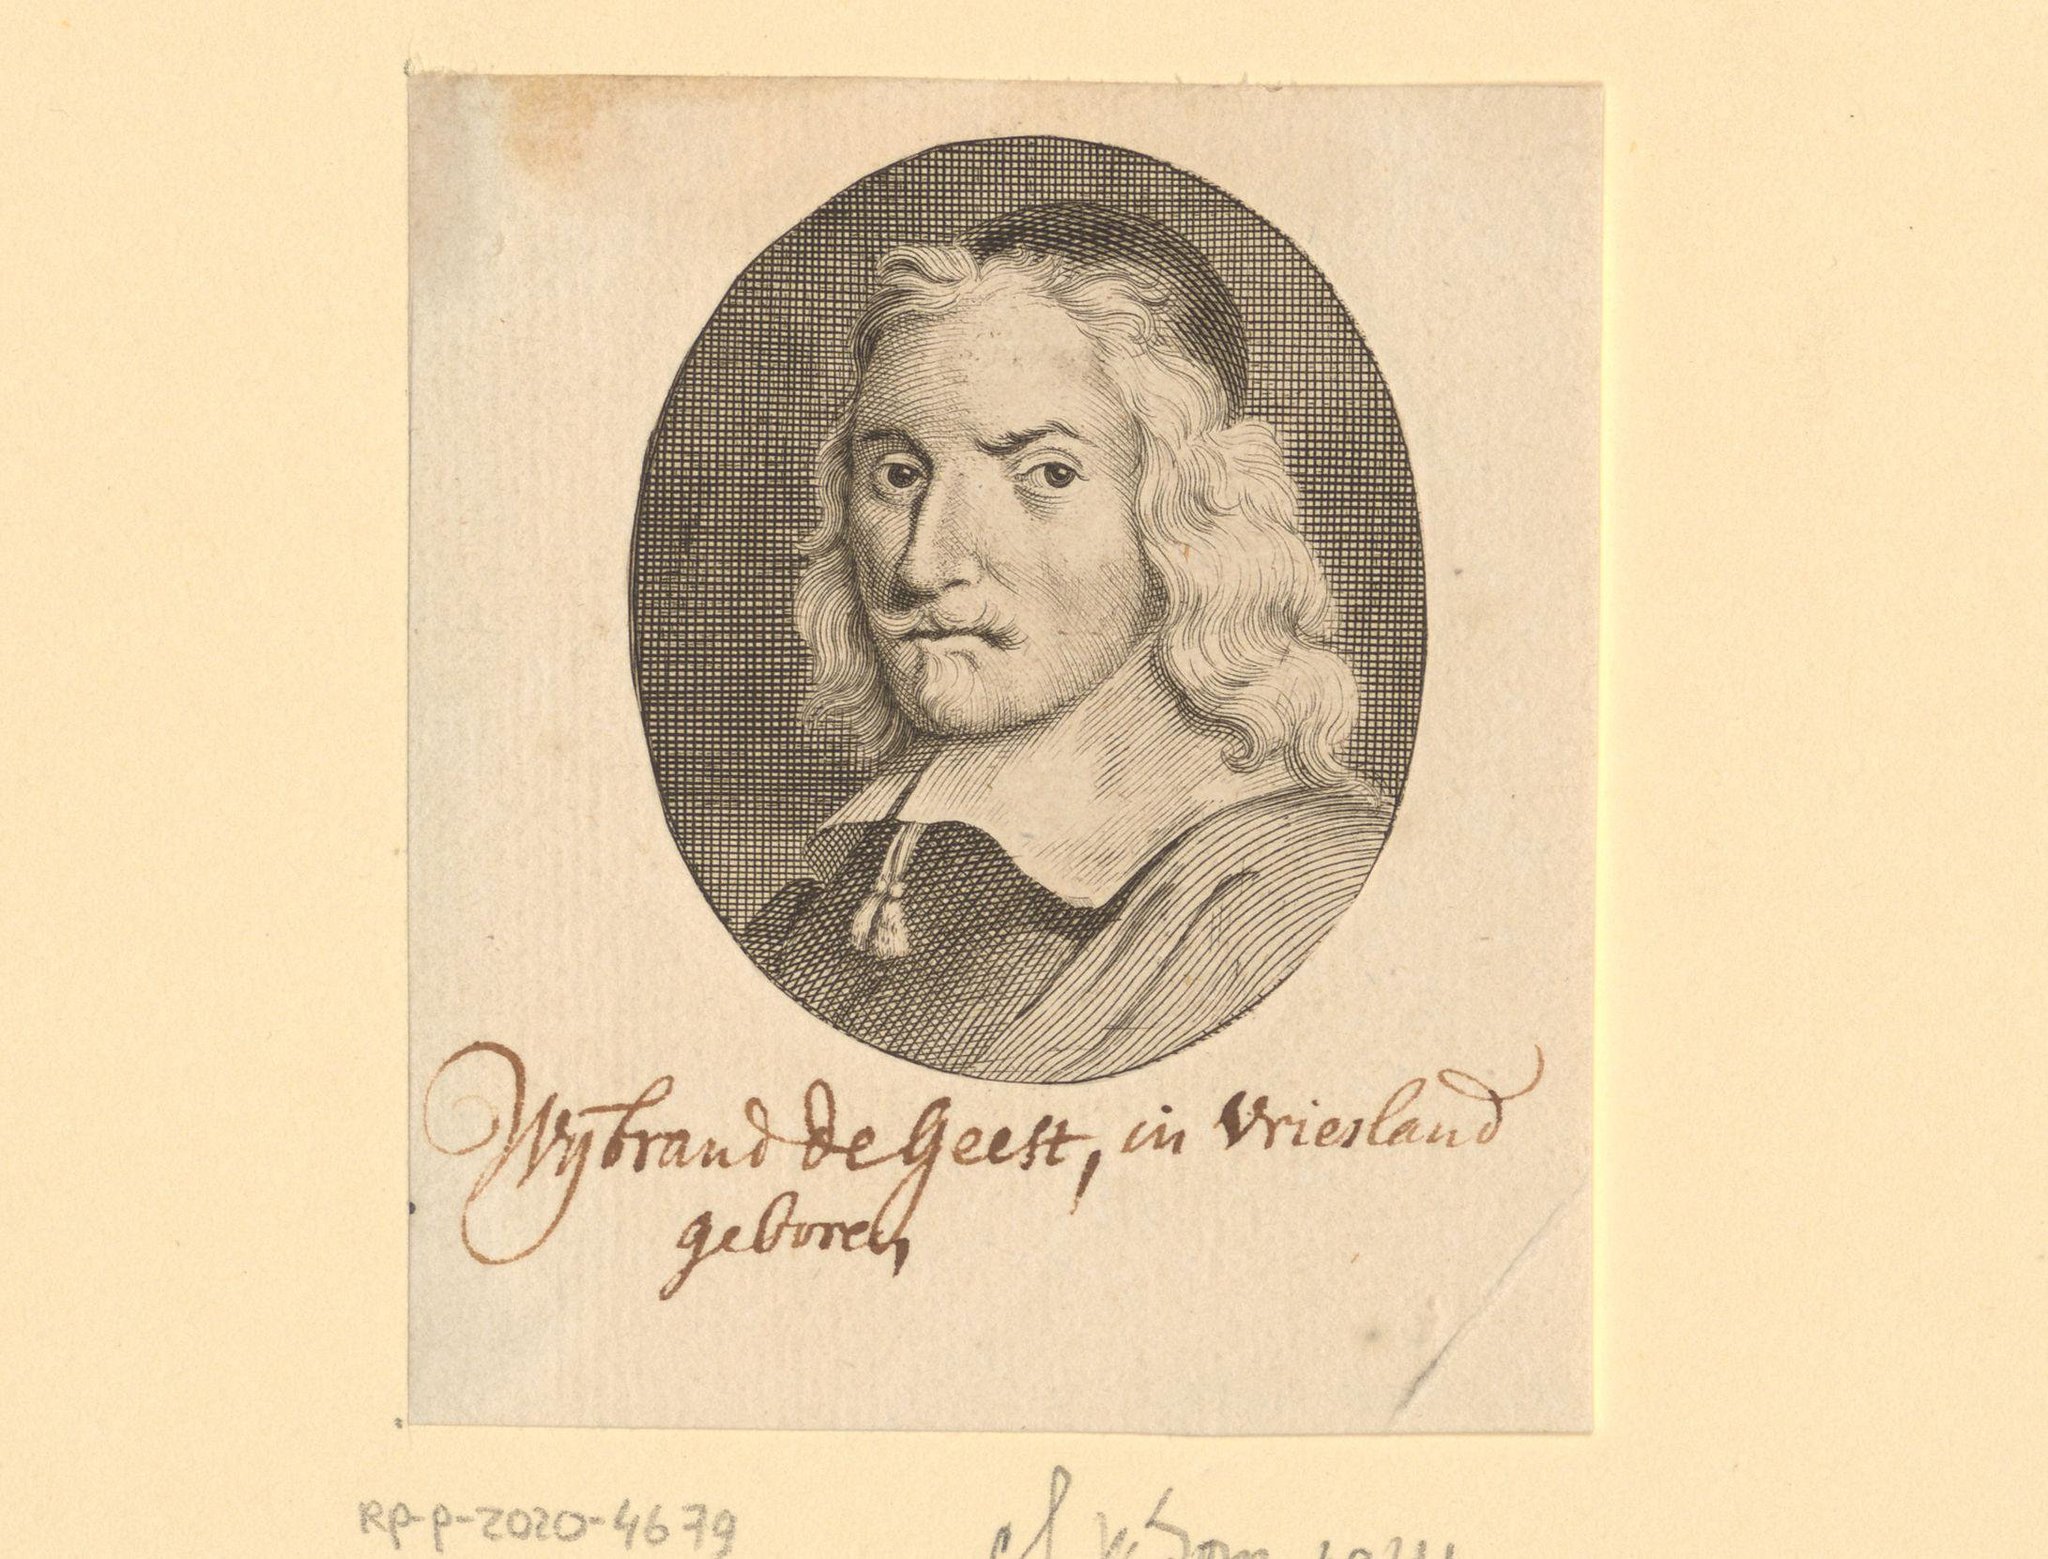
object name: print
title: Portret van Wybrand de Geest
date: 1718-1721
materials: paper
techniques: engraving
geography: amsterdam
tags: painter, draughtsman, wybrand de geest, historical persons, portrait, self-portrait of painter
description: Prent uit: Houbraken, Arnold. De groote schouburgh der Nederlantsche konstschilders en schilderessen (...). 3 dln. Amsterdam: Antonina Houbraken, 1718, dl. 1, p. 64.